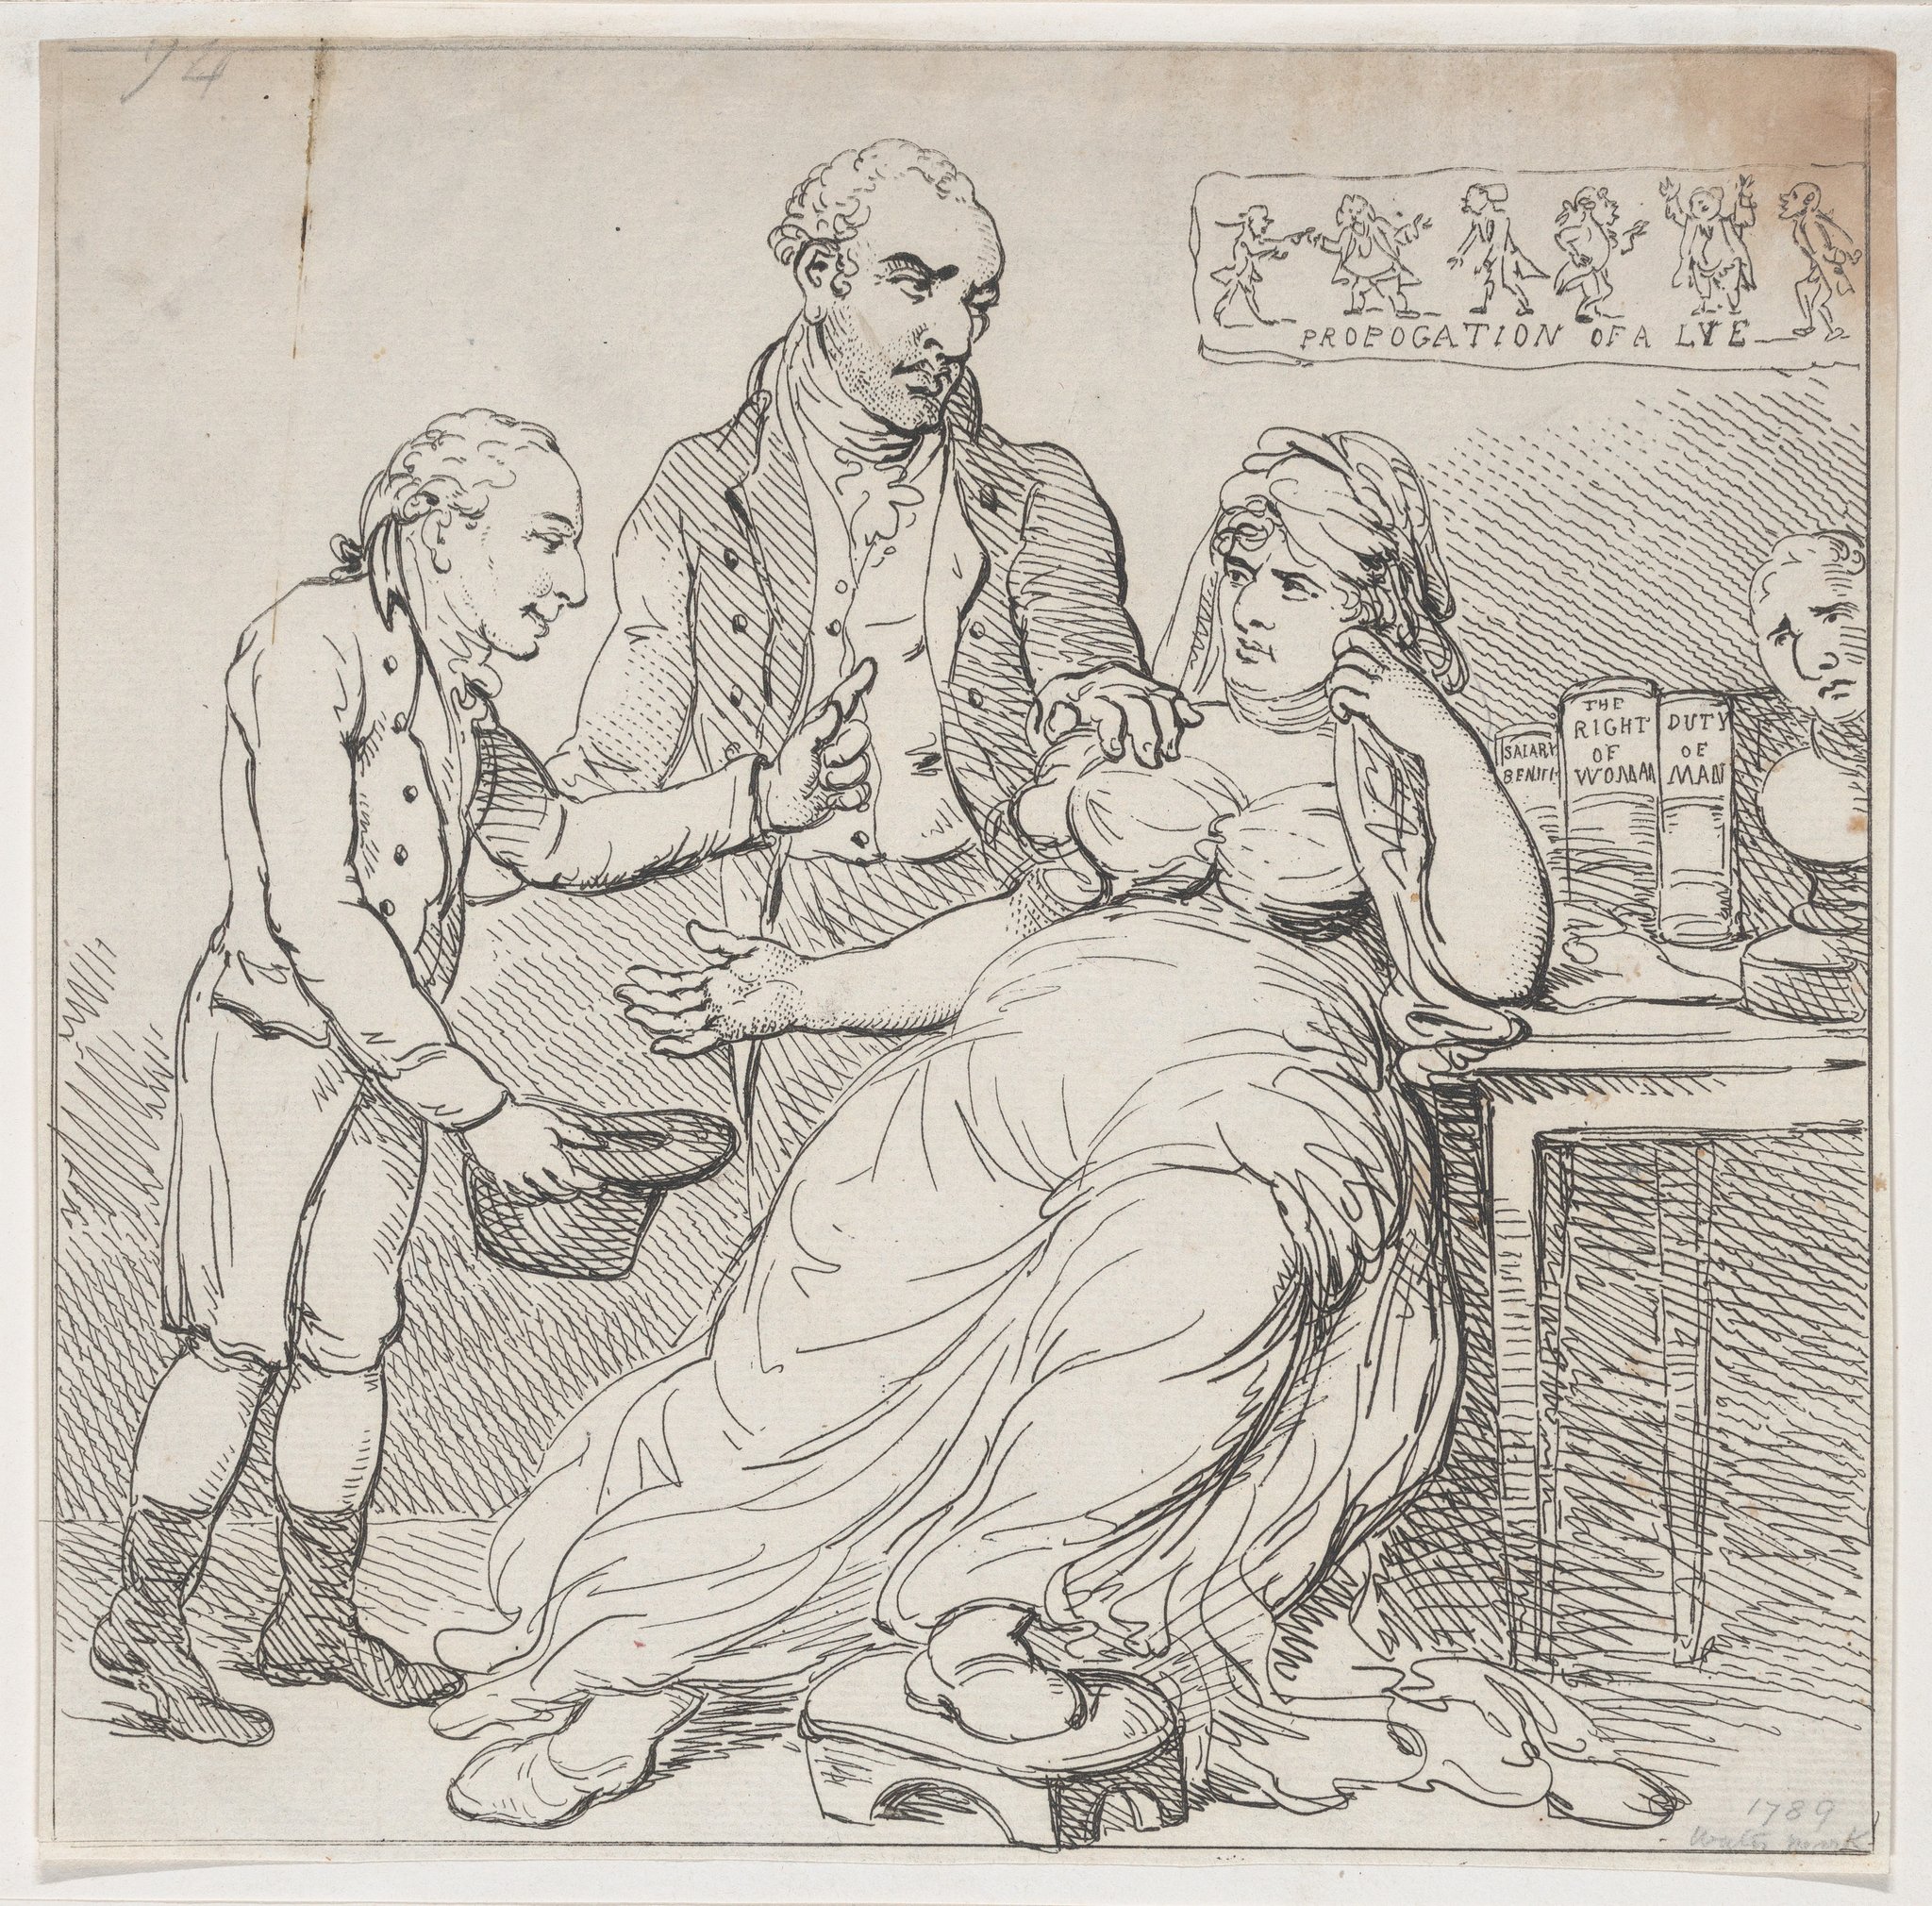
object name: print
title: Melpomene in the Dumps, or Child's Play Defended by Theatrical Monarchs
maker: thomas rowlandson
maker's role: artist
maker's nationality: british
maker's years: 1757-1827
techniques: etching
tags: satire,men,women